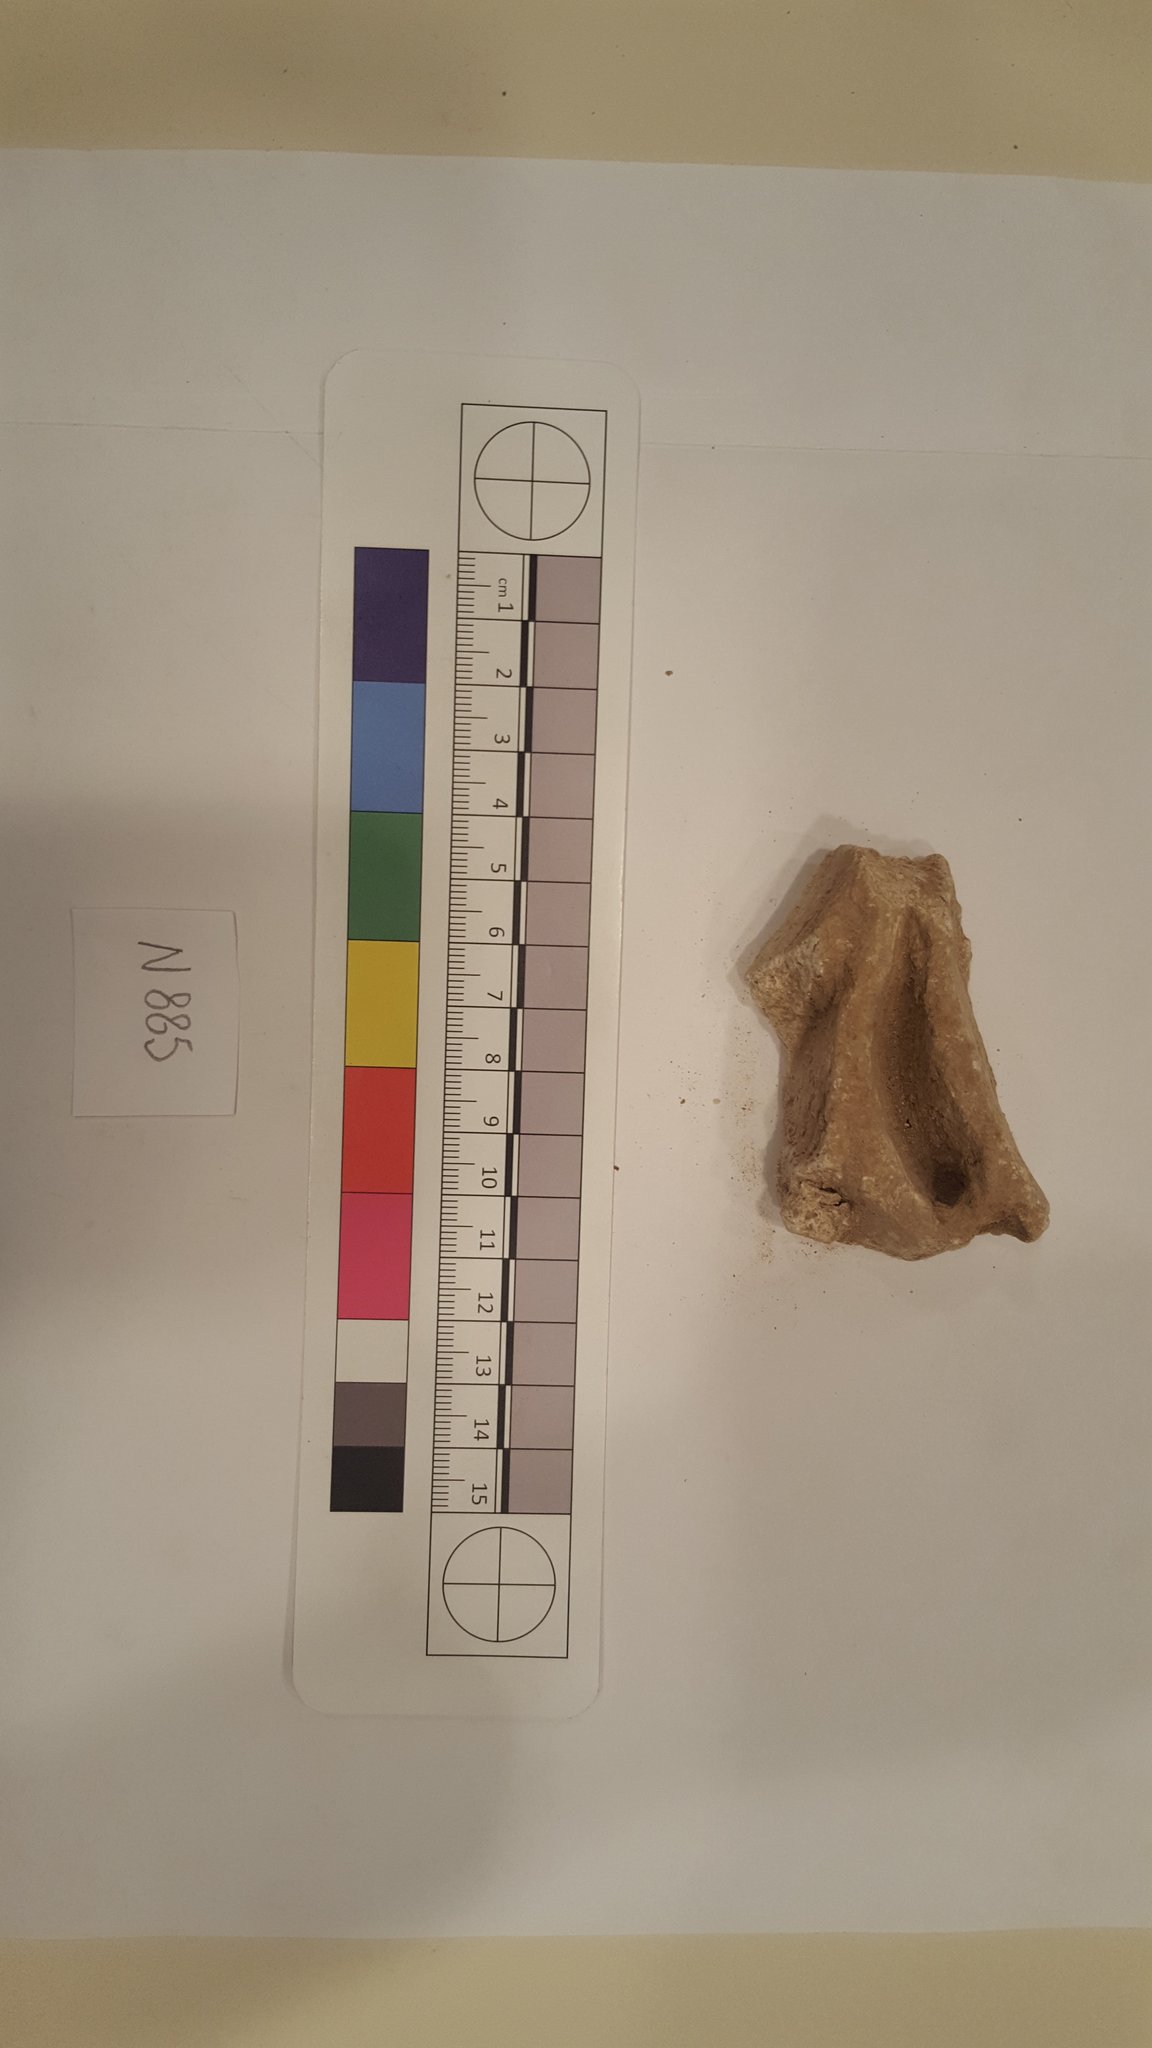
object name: fragment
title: Stucco Fragment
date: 701-1200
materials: plaster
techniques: carving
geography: iran